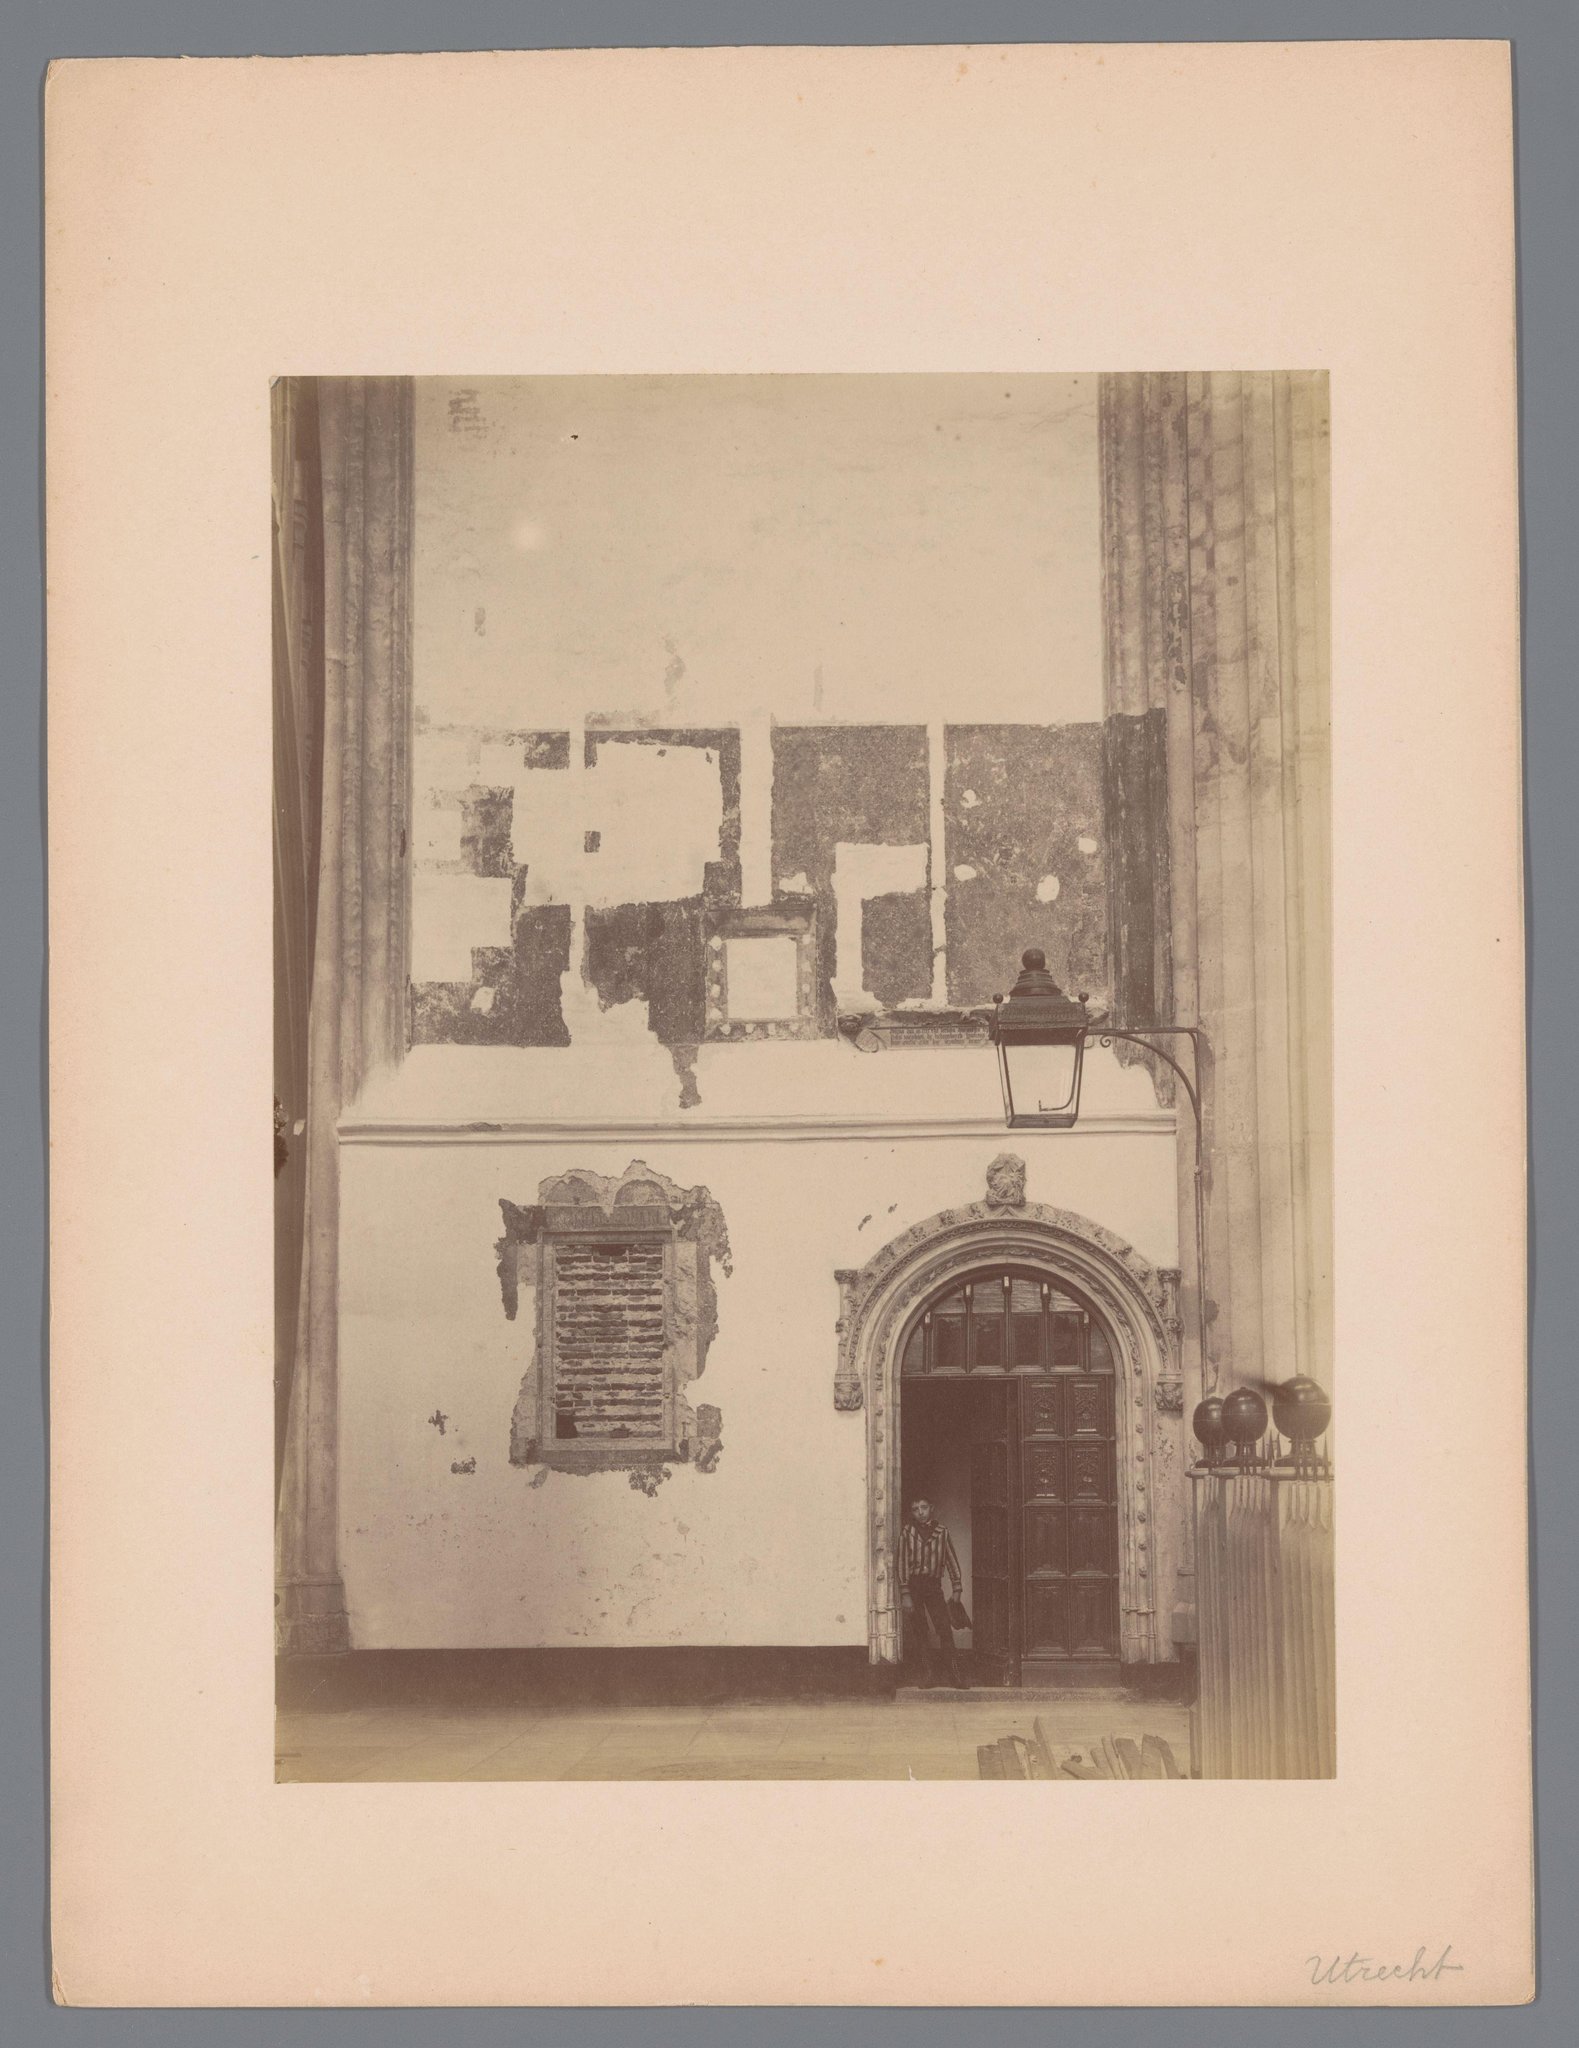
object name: photograph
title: Muurschilderingen in de Dom van Utrecht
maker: anoniem (monumentenzorg)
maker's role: fotograaf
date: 1891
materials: cardboard, photographic support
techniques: albumen print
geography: utrecht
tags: interior of church, picture, painting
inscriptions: annotation: ‘Utrecht’, annotation: ‘Domkerk te Utrecht/ gevonden muurschilderingen en deur der sacristie/ sept 1891’